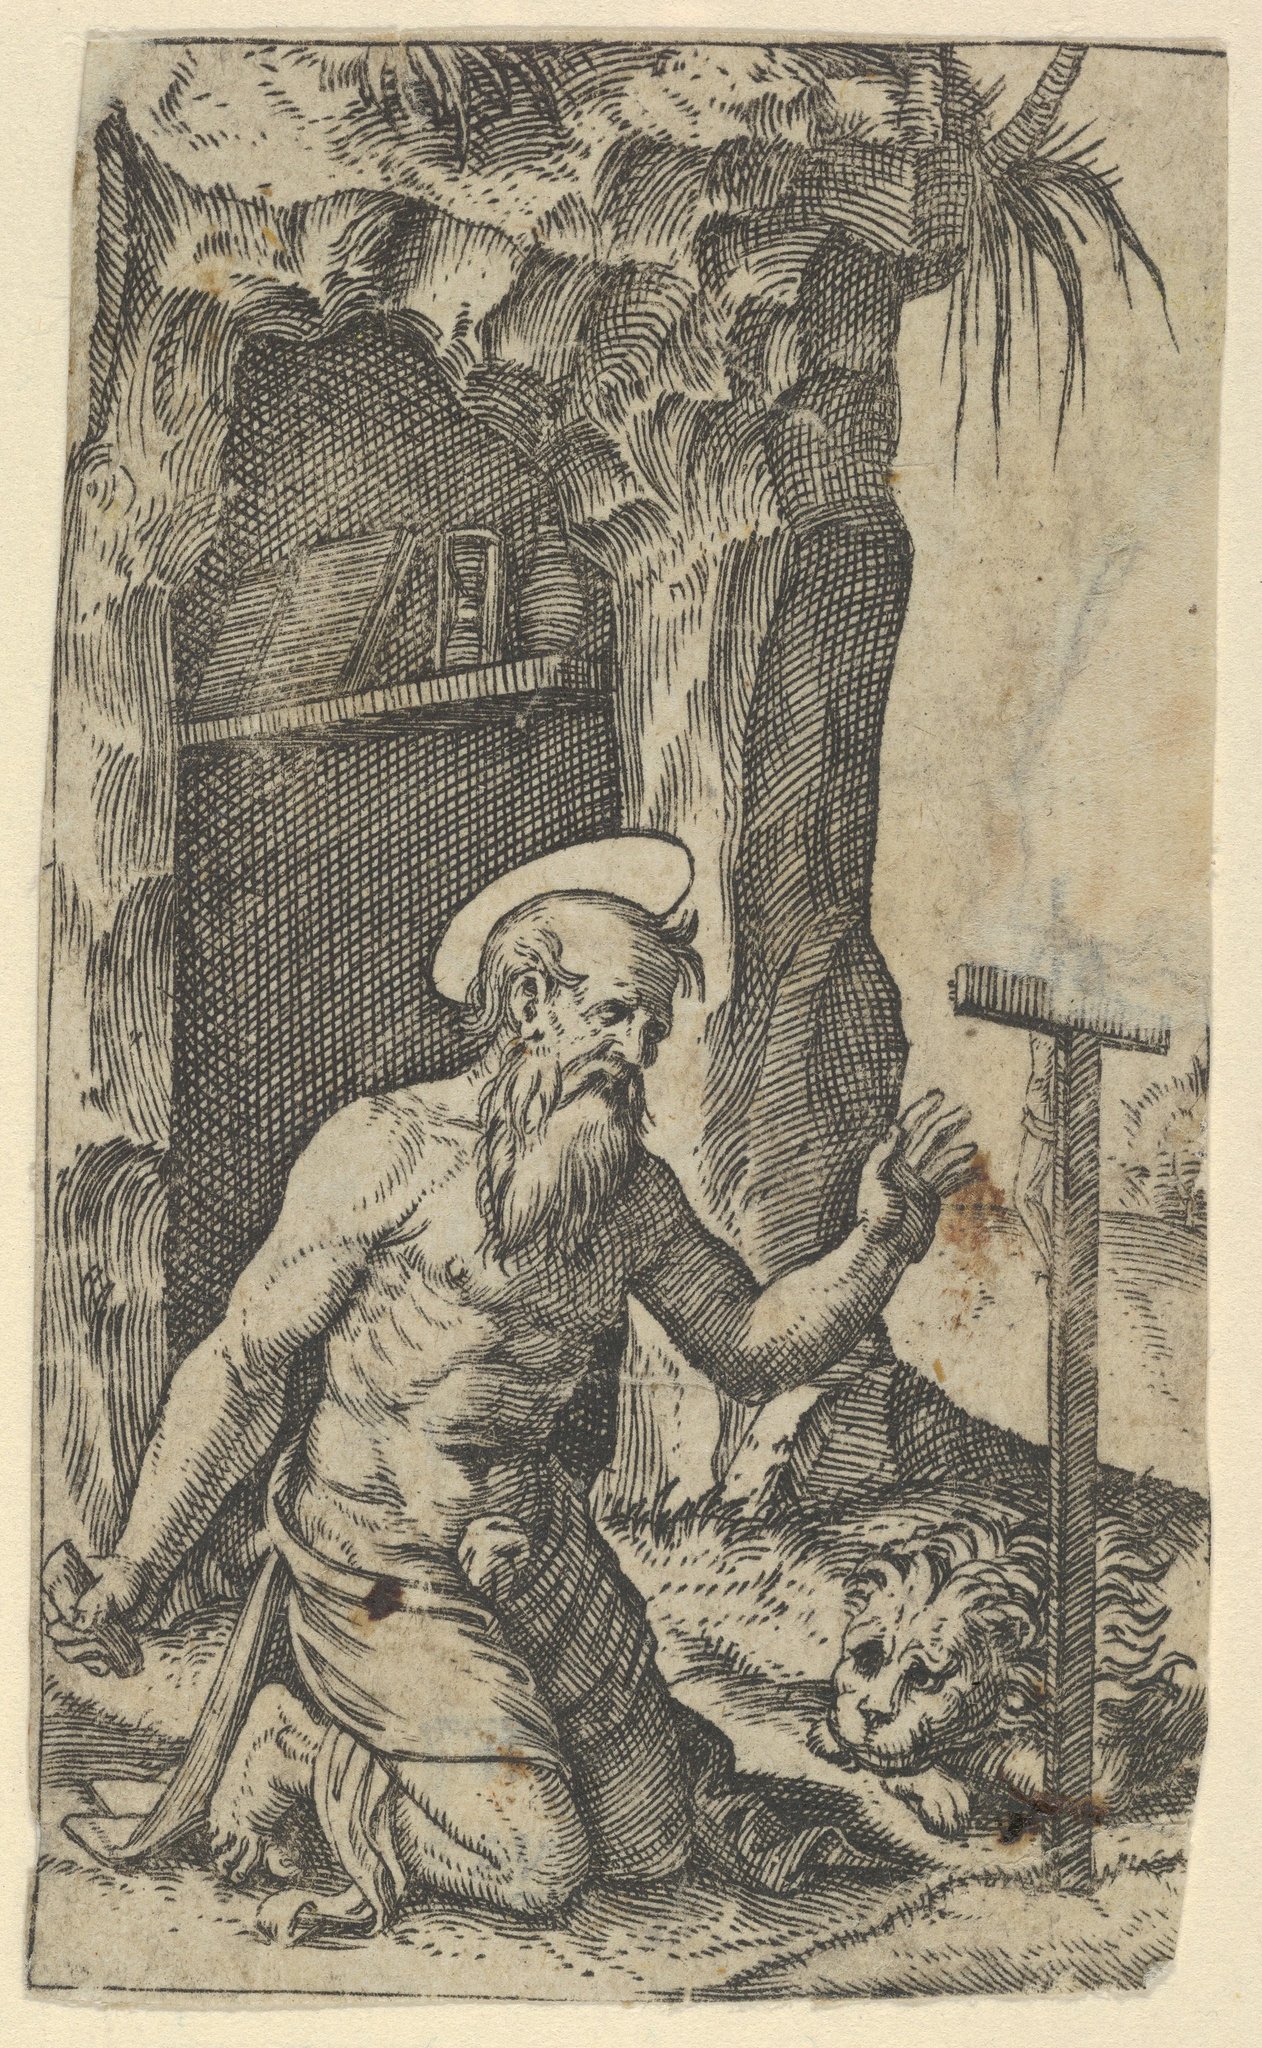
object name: print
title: Saint Jerome kneeling before a crucifix, from "Piccoli Santi" (Small Saints)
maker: marcantonio raimondi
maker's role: artist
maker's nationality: italian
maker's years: 1475-1534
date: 1500-1527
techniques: engraving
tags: saint jerome,crucifixion